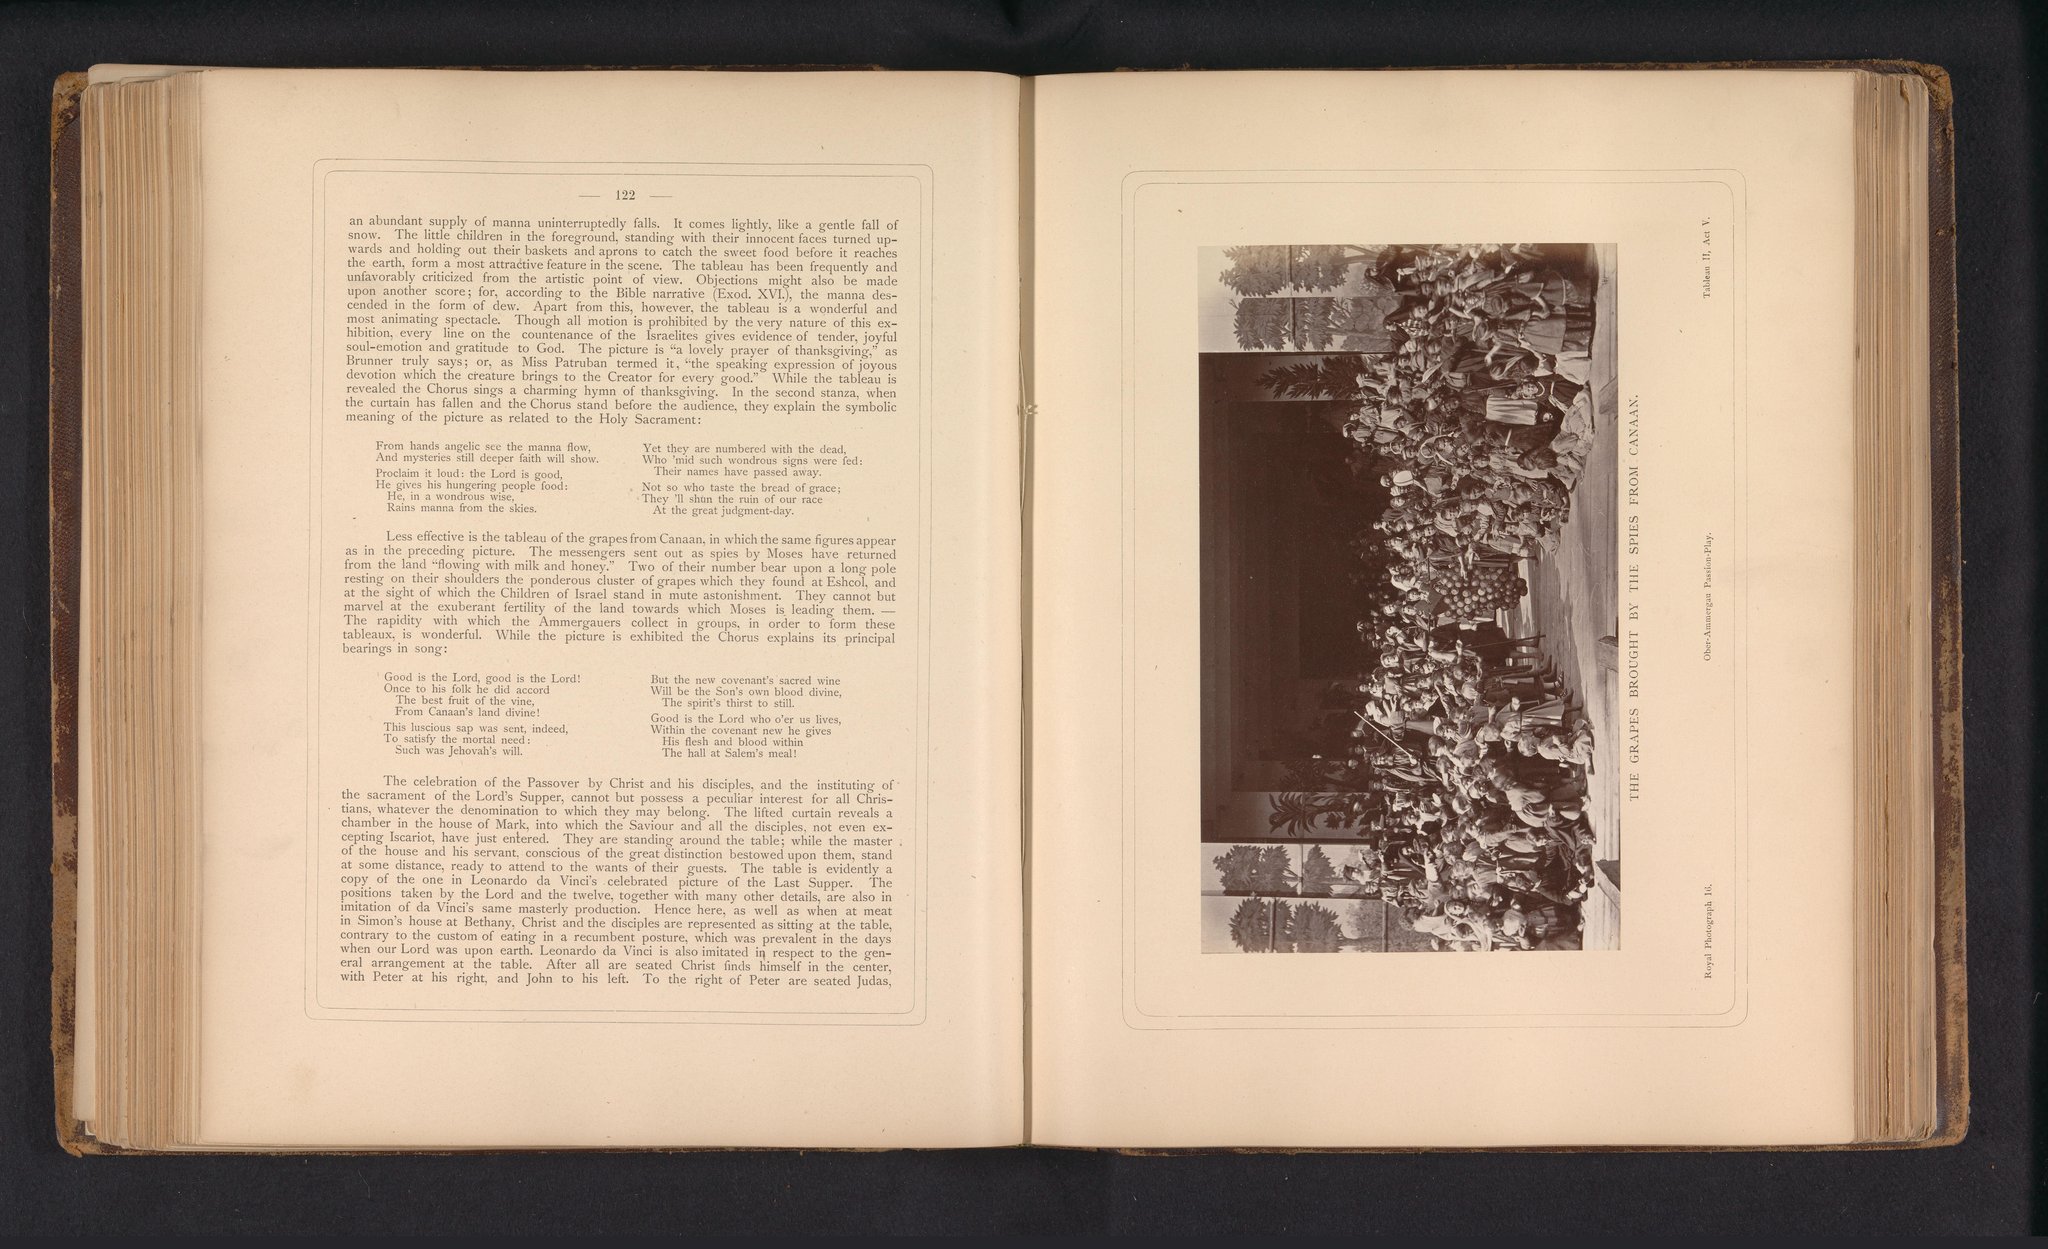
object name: page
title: The grapes brought by the spies from Canaan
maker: joseph albert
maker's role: printer, publisher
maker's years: 1825-1886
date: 1868-1873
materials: photographic support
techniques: albumen print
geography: oberammergau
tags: the spies take away some of the fruits of canaan and return, usually carrying a large bunch of grapes on a pole, group of actors, troupe; actors on the stage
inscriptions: number: ‘Royal Photograph 16.’